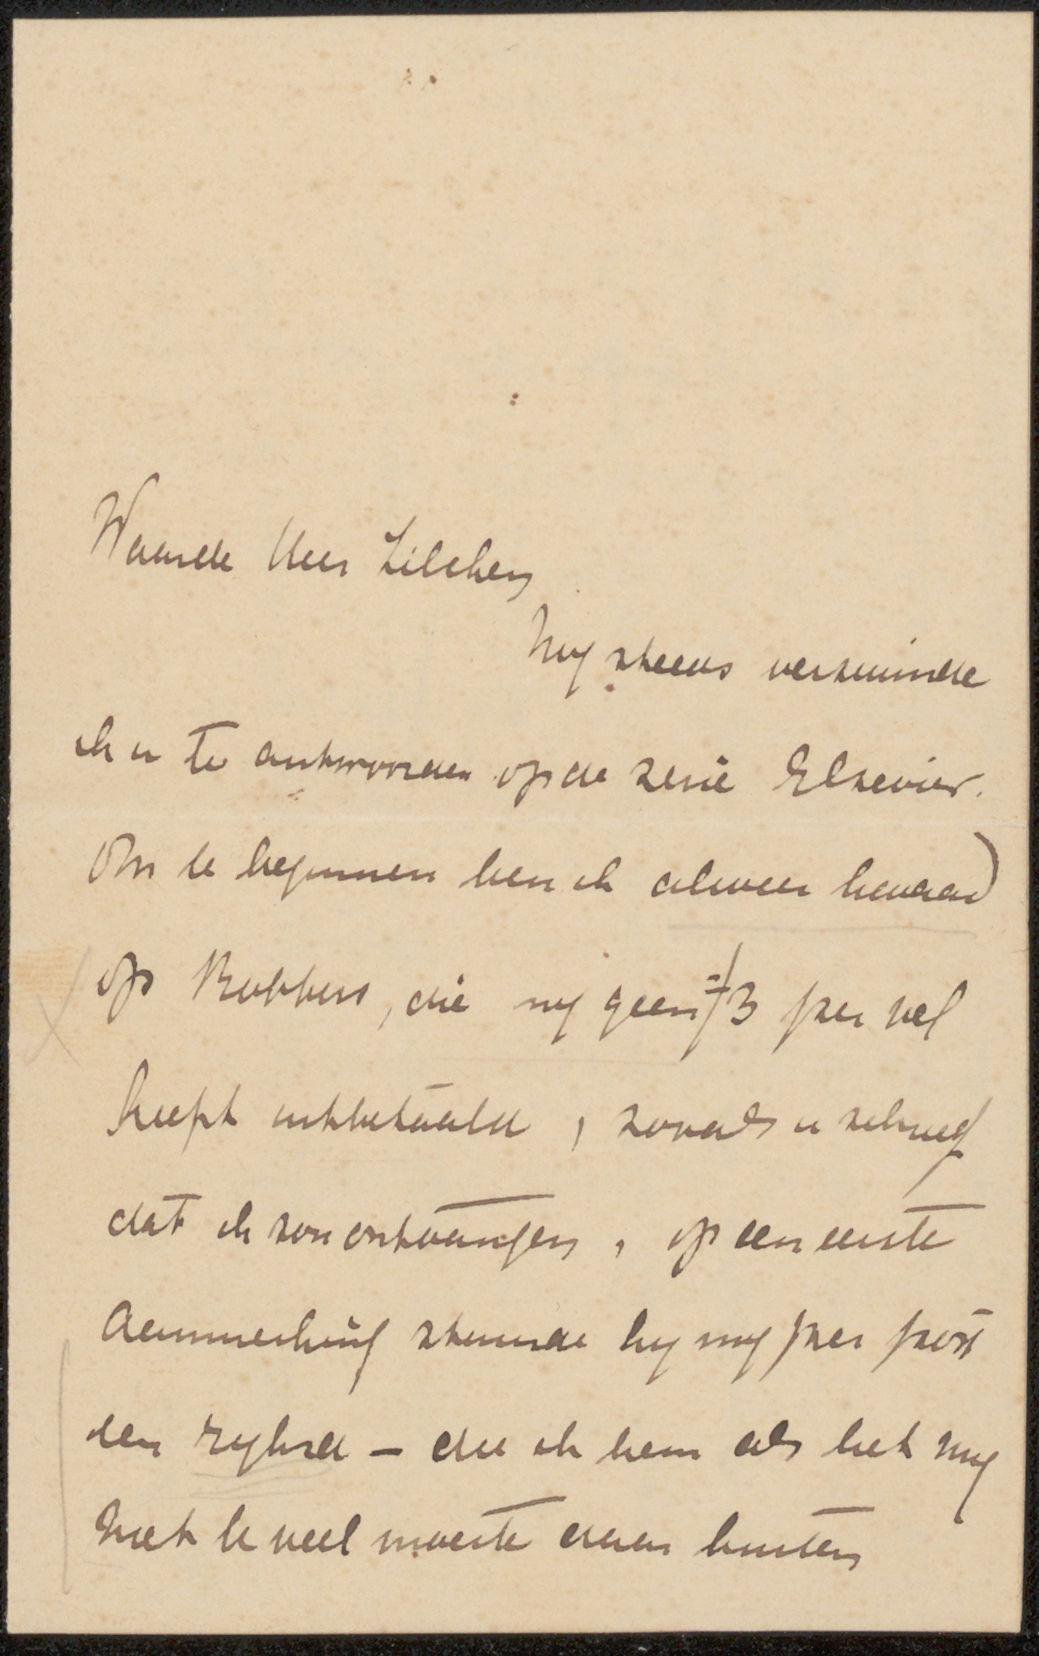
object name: letter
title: Brief aan Philip Zilcken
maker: grada hermina marius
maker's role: painter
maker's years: 1854-1919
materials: ink, paper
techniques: pen, writing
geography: the hague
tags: amsterdam, painter, print maker, draughtsman, designer, jan veth, the hague, jacob maris, geo poggenbeek, den bosch, antoon derkinderen, jan voerman (1857-1941), nicolaas bastert, herman robbers, philip zilcken, money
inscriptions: collector's mark: ‘RPK’